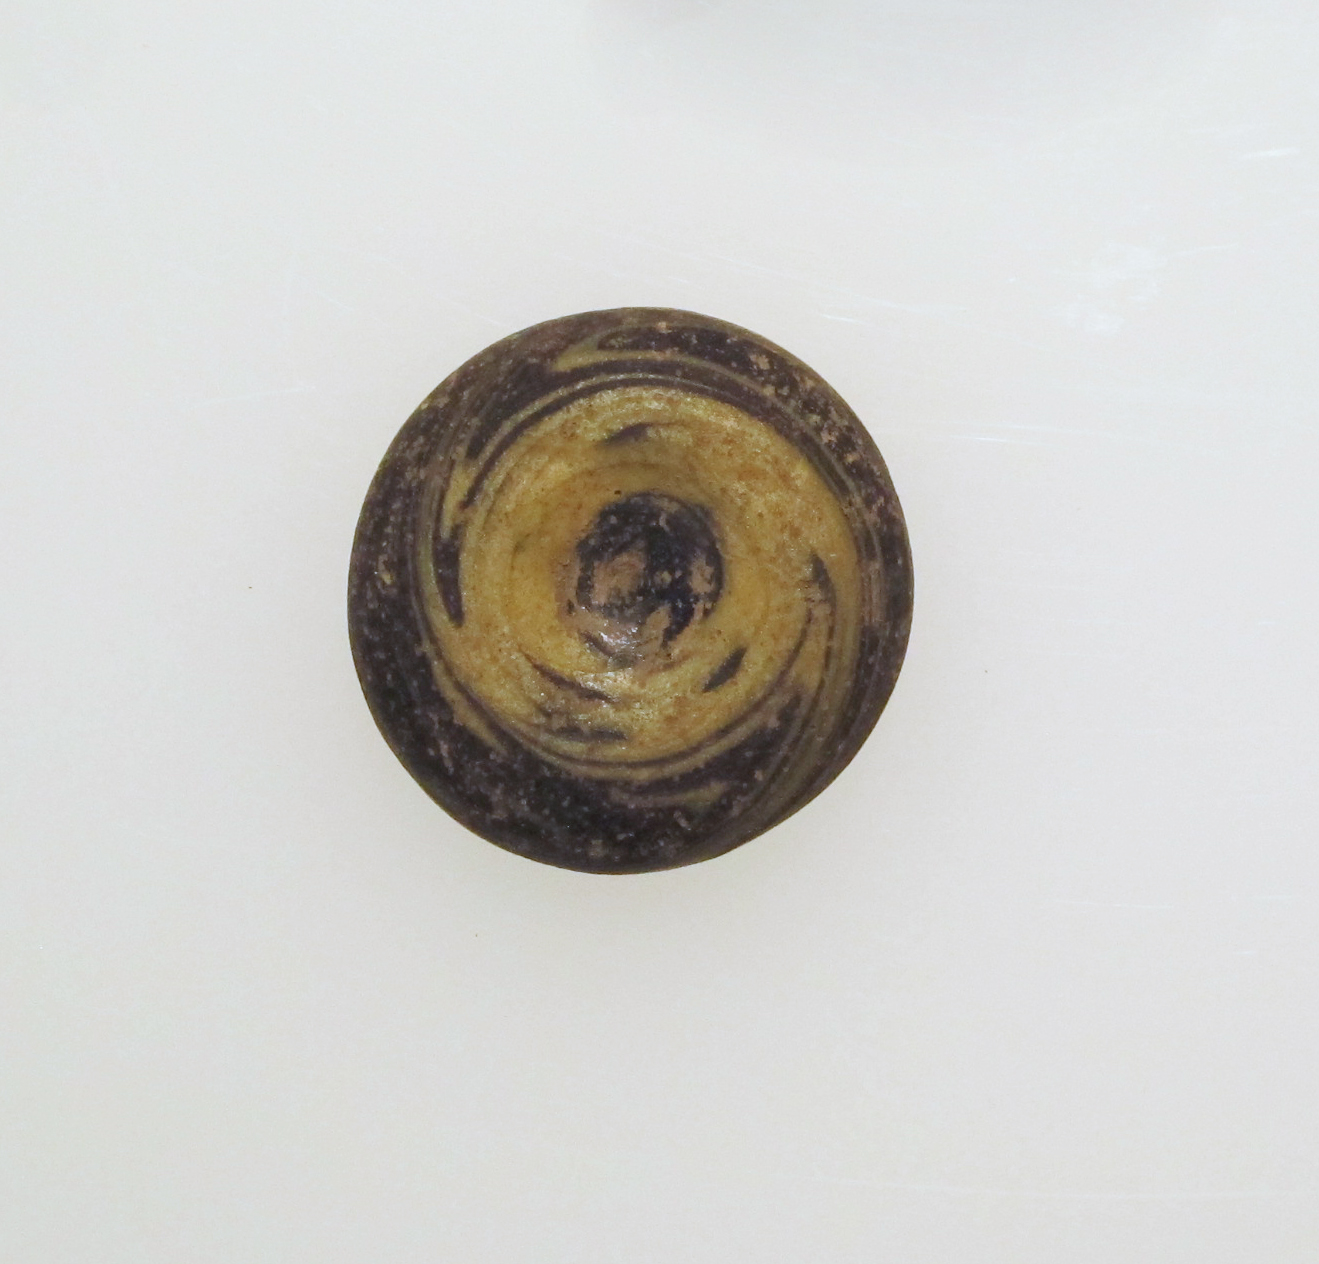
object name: pinhead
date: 7000 BCE-330 CE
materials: glass